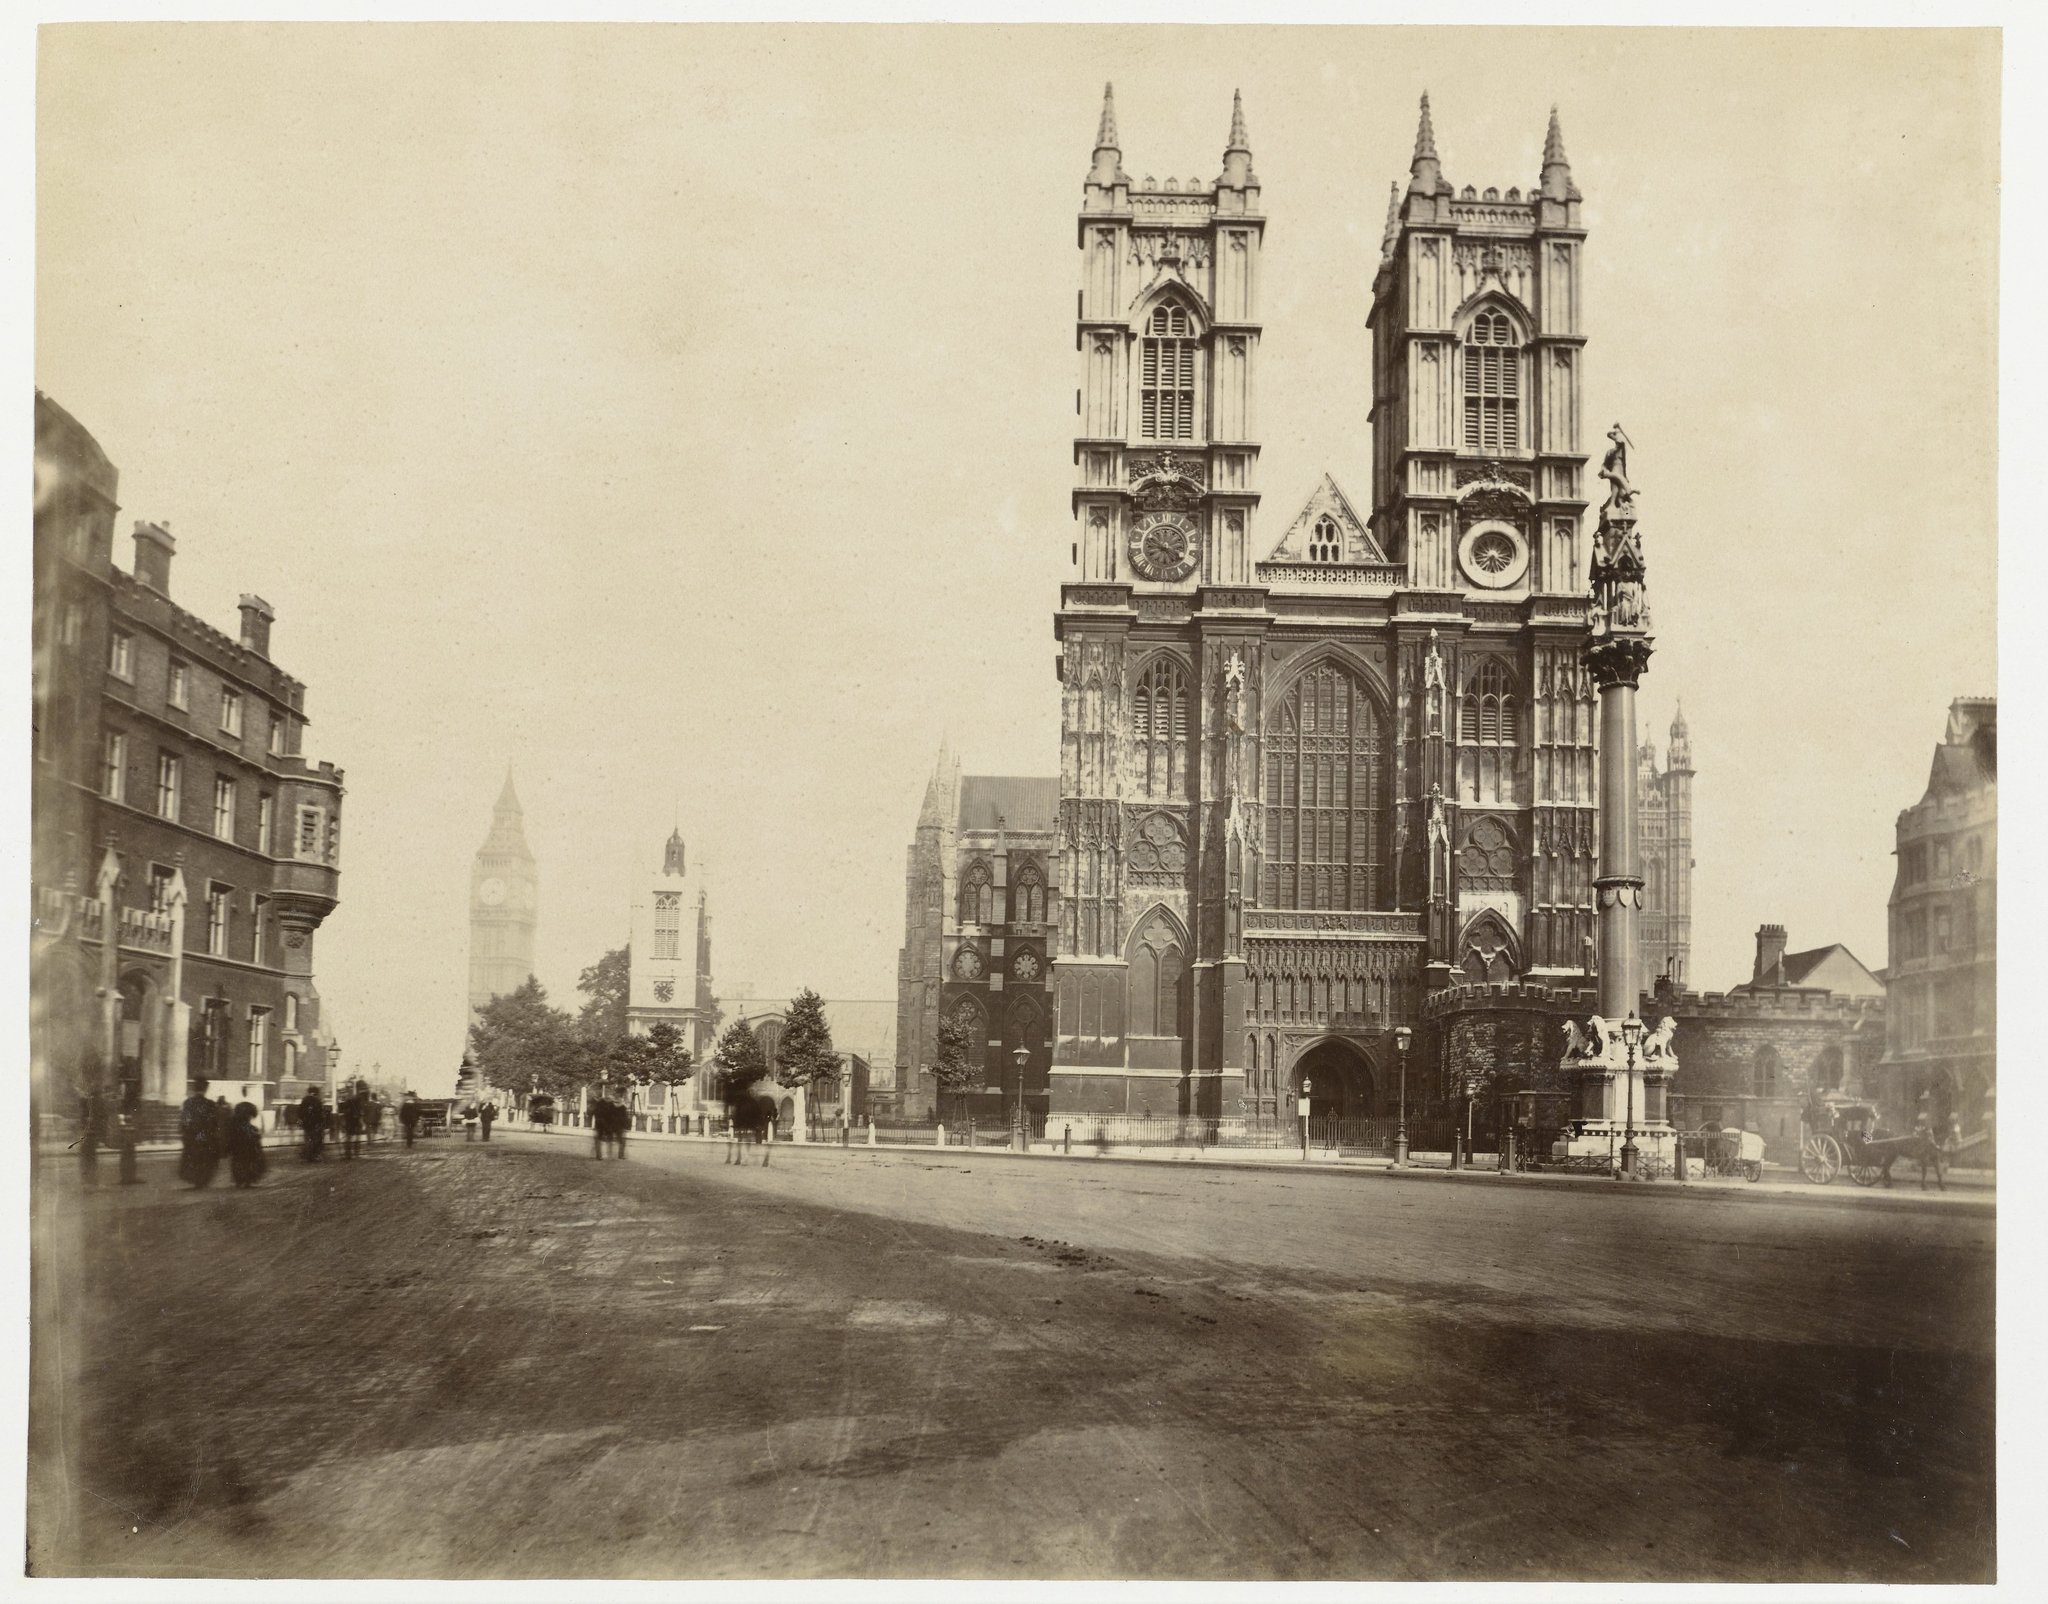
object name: photograph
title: Westminster Abbey in Londen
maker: Anonymous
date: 1855-1900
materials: cardboard, paper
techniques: albumen print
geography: london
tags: interior of church, westminster abbey